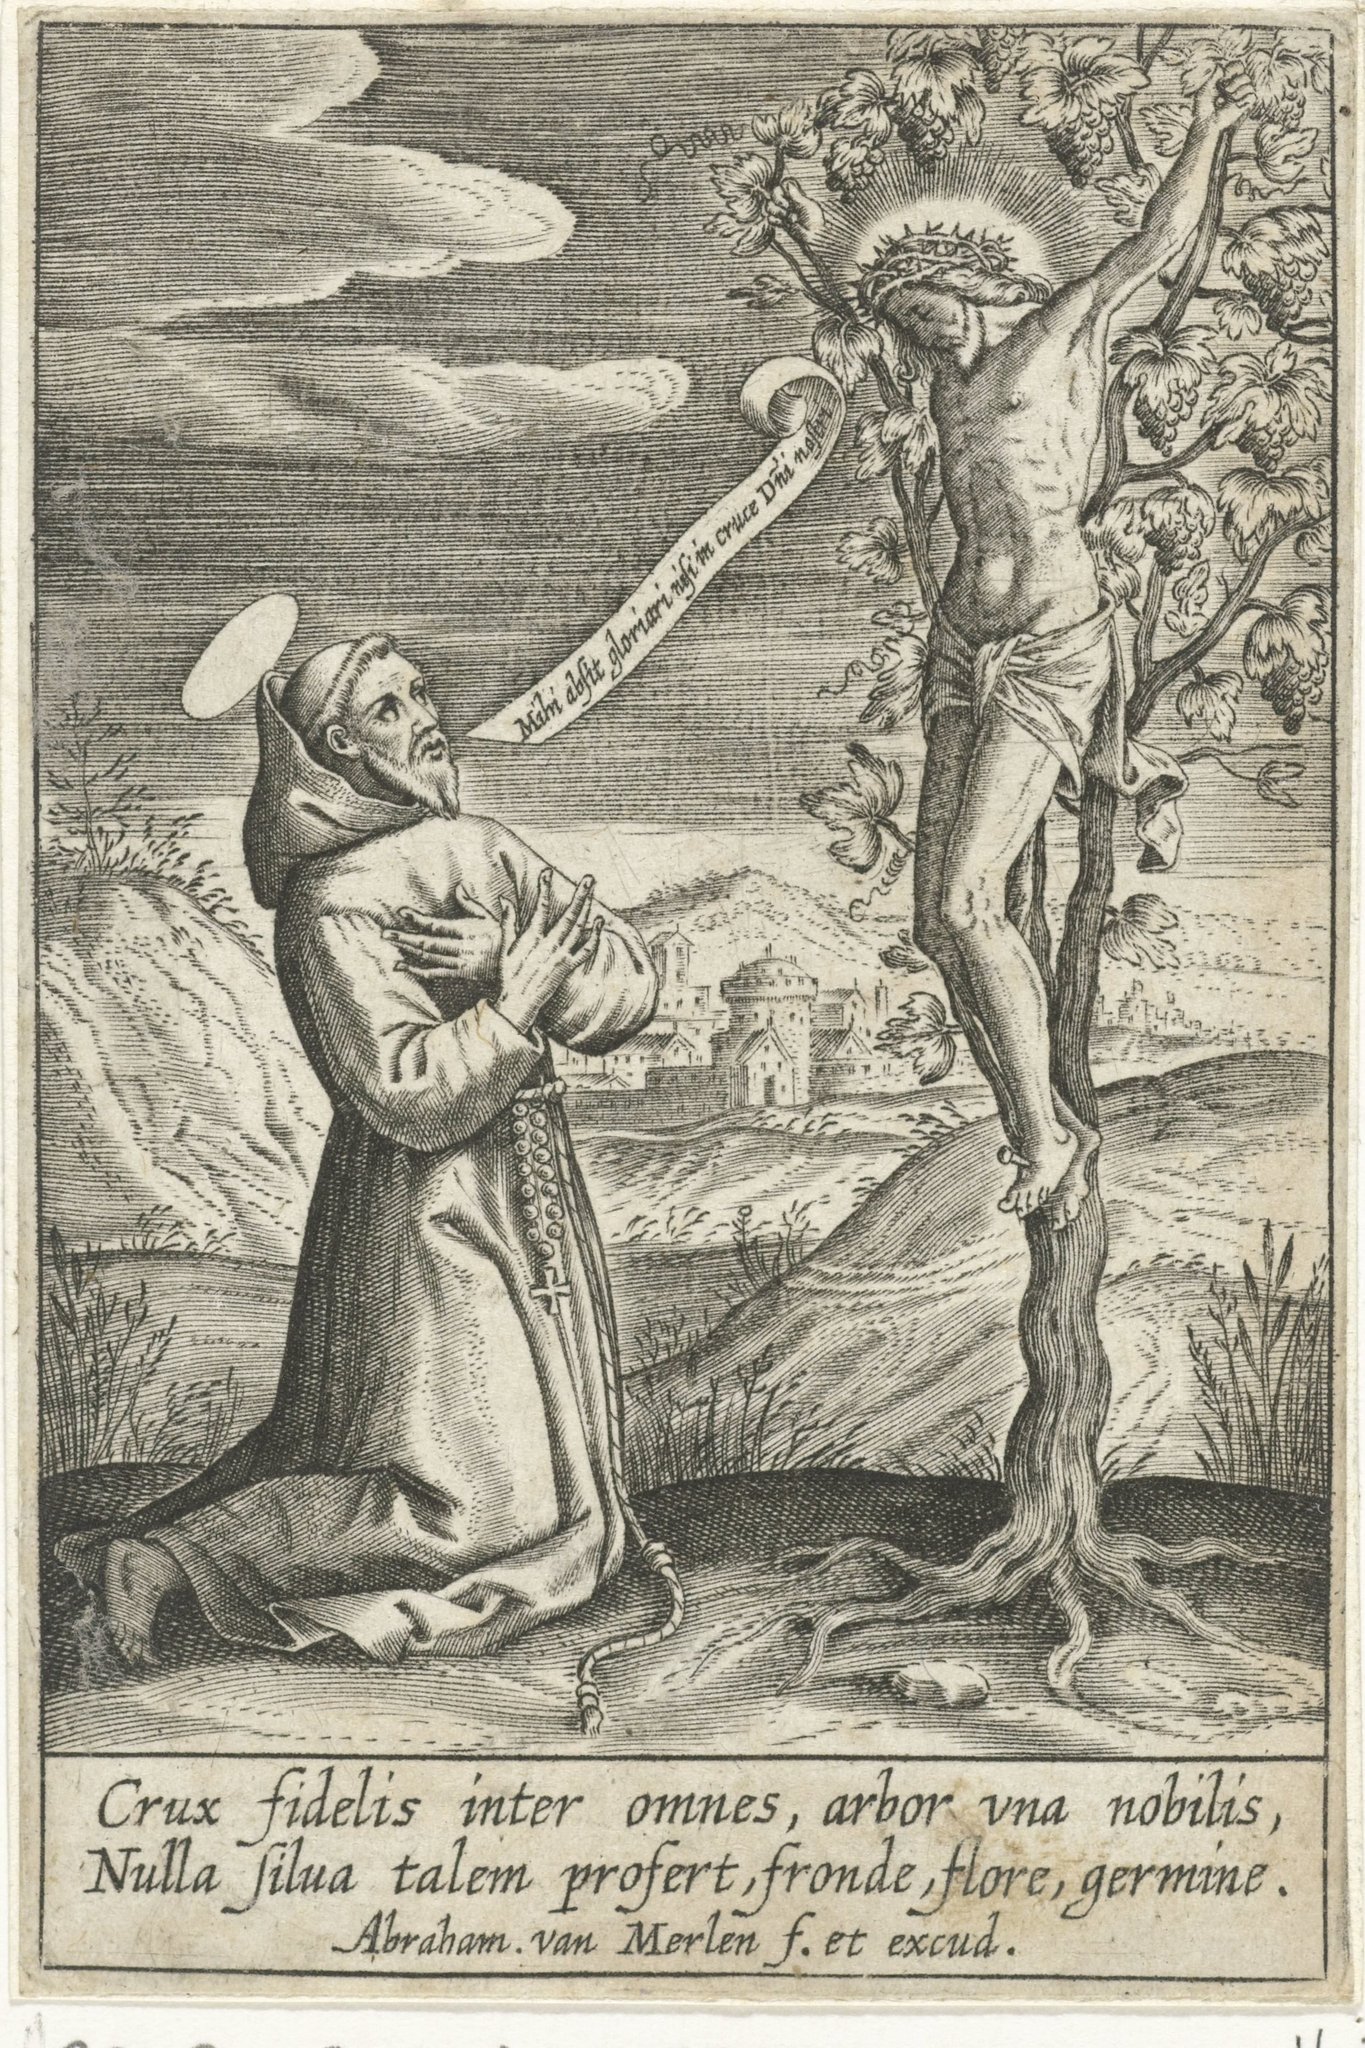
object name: print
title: Knielende heilige voor Christus aan het kruis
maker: abraham van merlen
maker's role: print maker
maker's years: 1579-1660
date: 1600-1660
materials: paper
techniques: engraving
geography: antwerp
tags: christ crucified on a tree or on a vine, kneeling figure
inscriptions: collector's mark: Lugt 2228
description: Een heilige, gekleed in monnikspij, geknield voor een aan een wijnstok gekruisigde Christus.